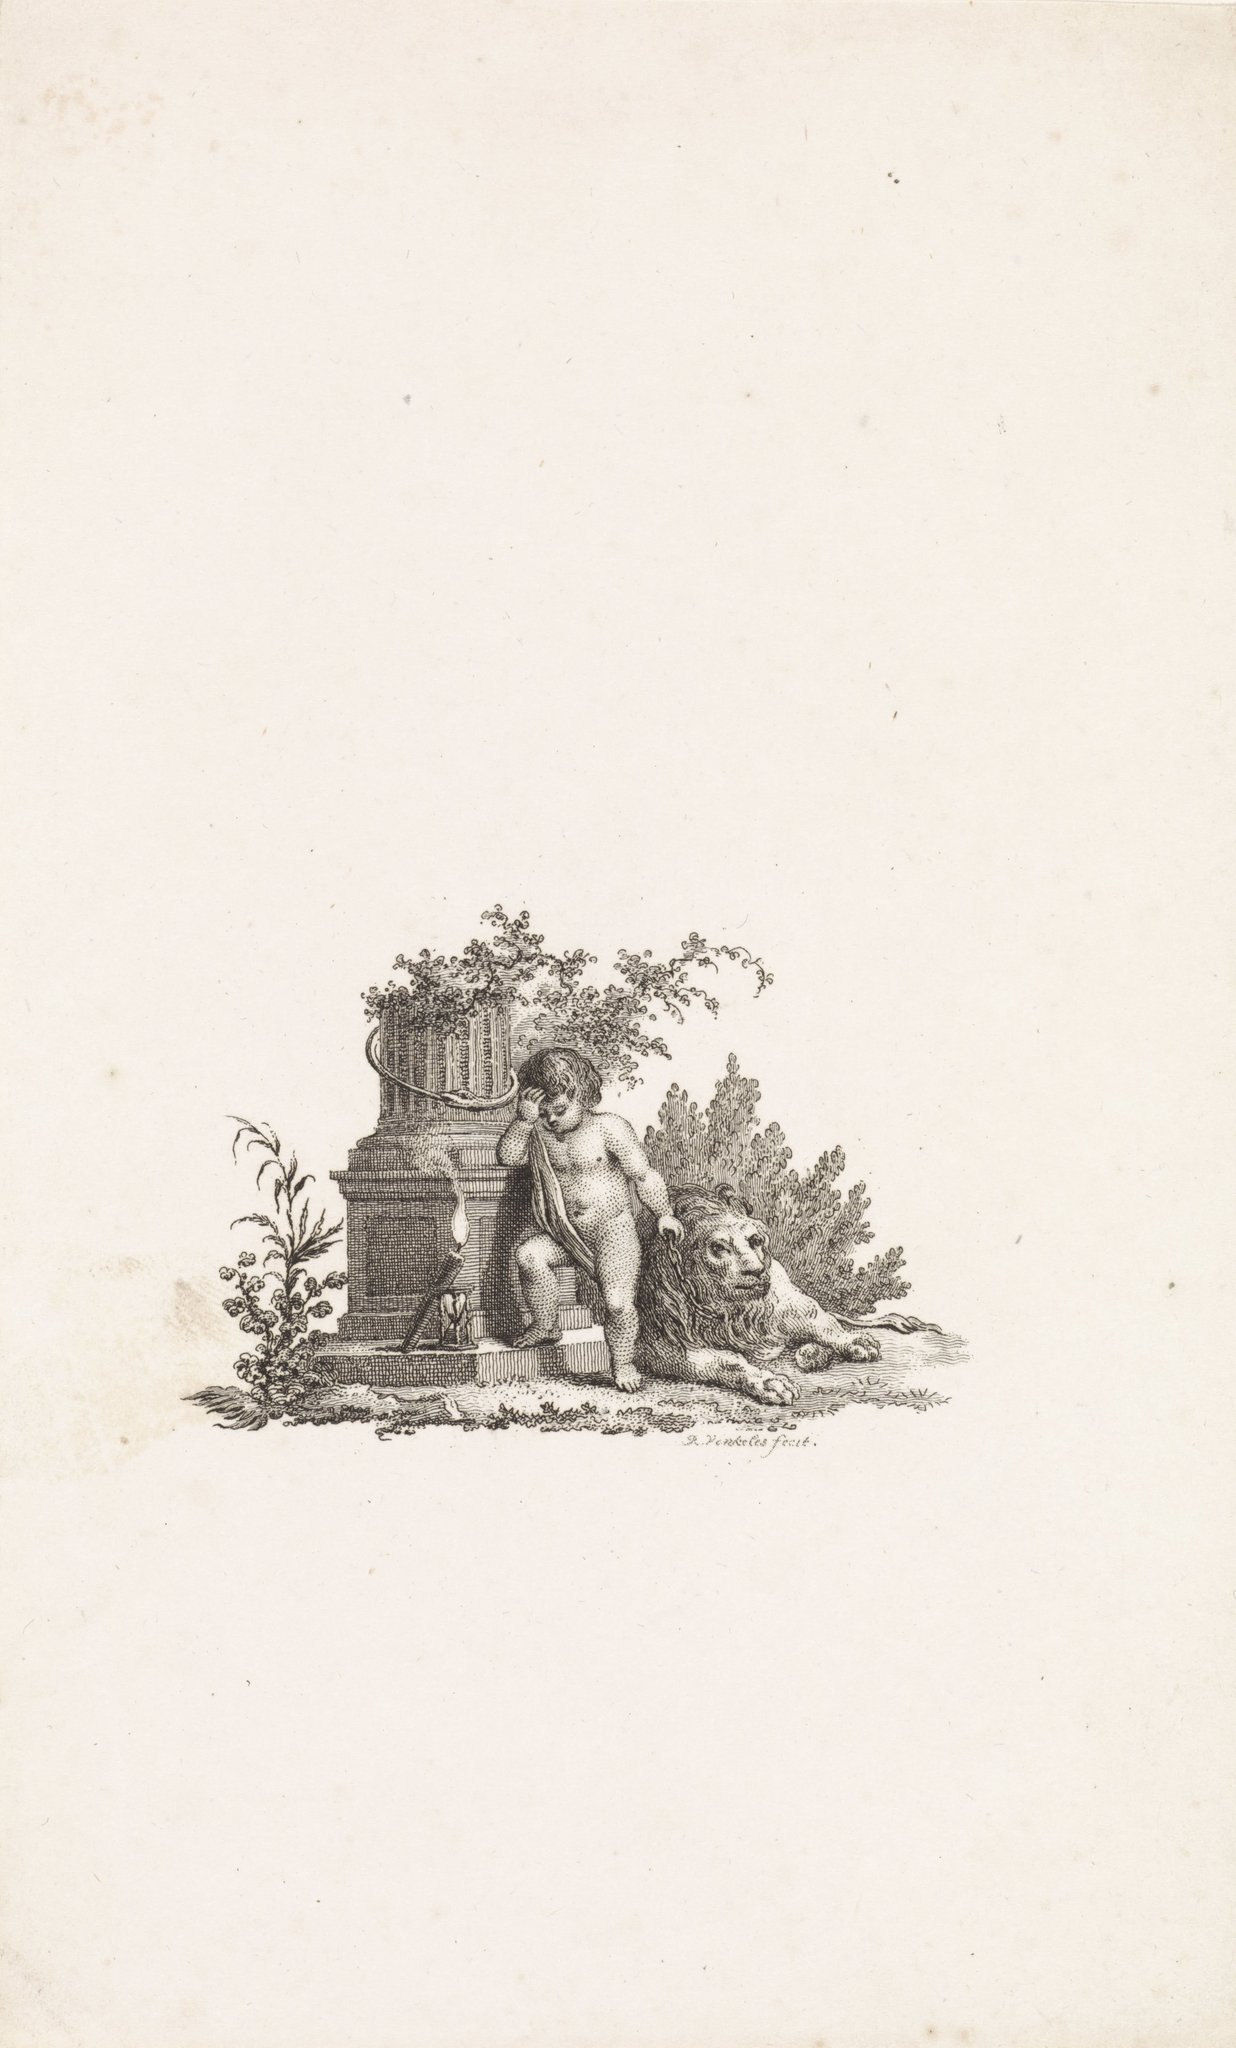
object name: print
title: Treurende putto bij een geruïneerde zuil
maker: reinier vinkeles (i)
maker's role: draughtsman, print maker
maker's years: 1741-1816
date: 1751-1816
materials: paper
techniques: engraving, etching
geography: amsterdam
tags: hourglass, serpent ouroboros, beasts of prey, predatory animals: lion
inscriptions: collector's mark: Lugt 2228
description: Treurende putto met een geketende leeuw bij een geruïneerde zuil. Om de zuil een slang die in zijn eigen staart bijt, een symbool voor eeuwigheid. Aan de voet van de zuil een fakkel en een zandloper.